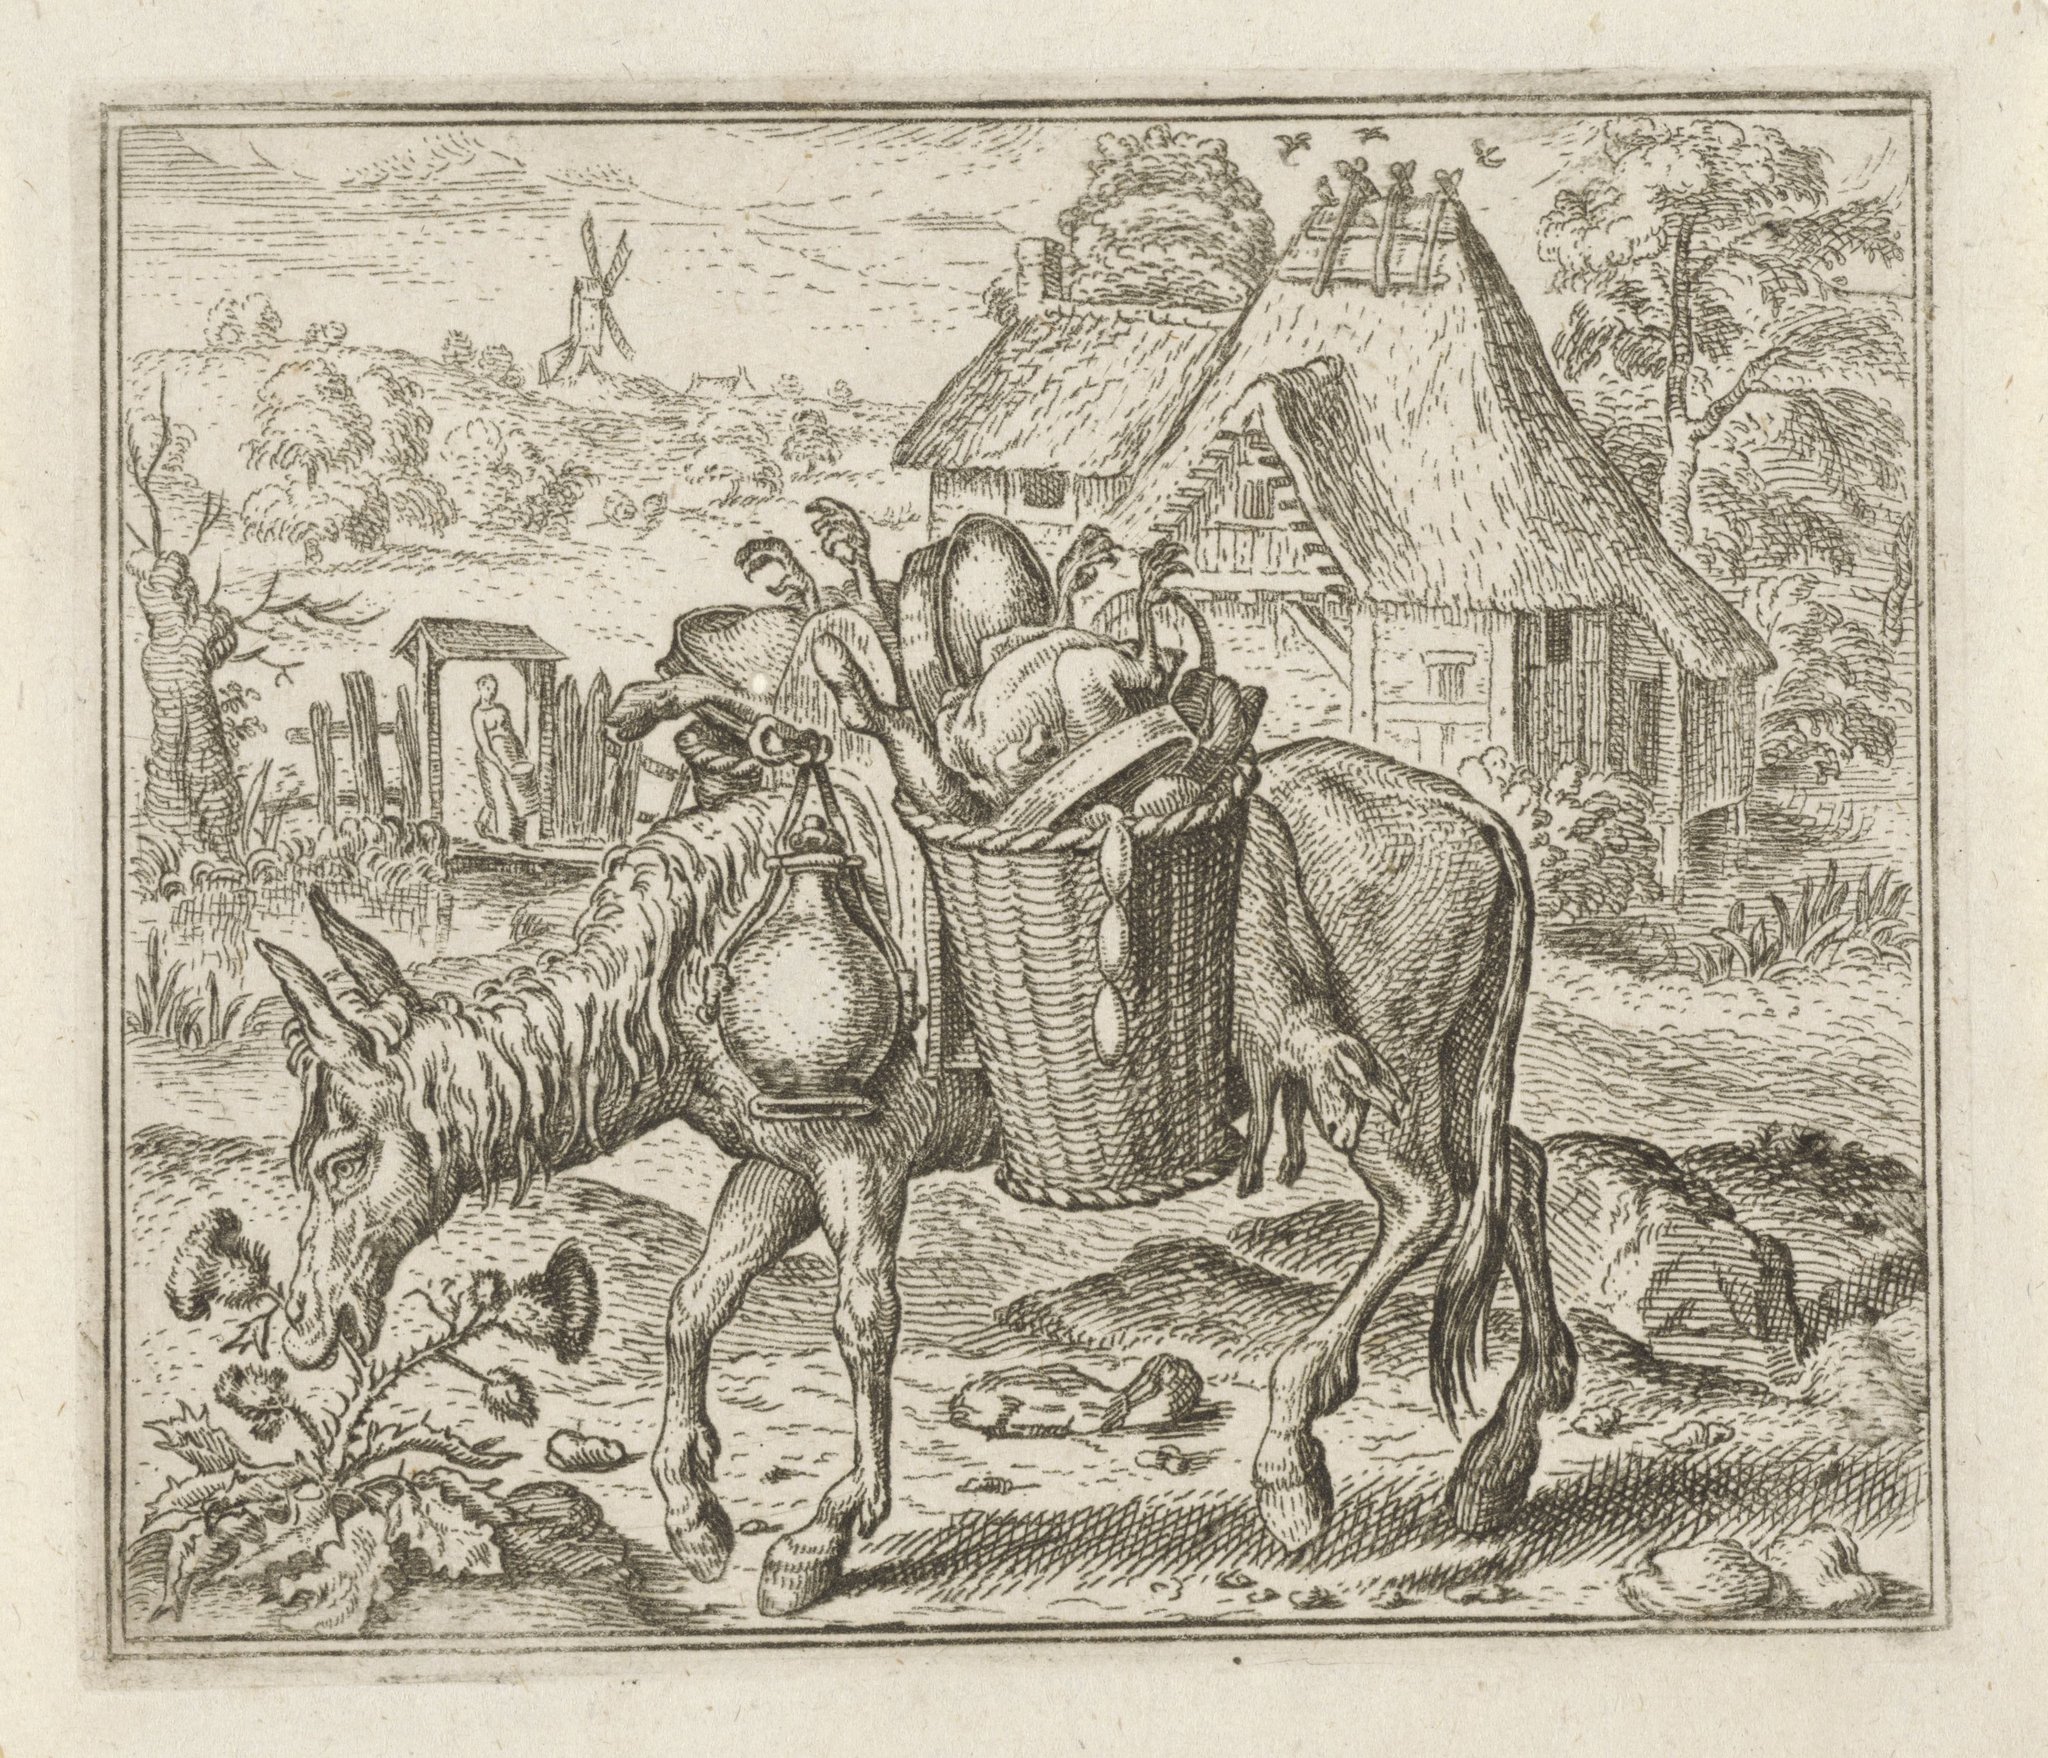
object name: print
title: Fabel van de ezel beladen met lekkernijen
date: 1608-1679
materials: paper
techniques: etching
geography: prague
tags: ass, donkey, fables, foodstuffs; still life of foodstuffs, plants and herbs: thistle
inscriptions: collector's mark: Lugt 2228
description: Een ezel, rijk beladen met allerlei lekkernijen, kauwt op een distel. Op de achtergrond een boerderij. De fabel beschrijft hoe een ezel ondanks de etenswaar op zijn rug steeds distels eet. De moraal van het verhaal leert dat een rijkaard ondanks zijn weelde altijd een reden vindt om te klagen.